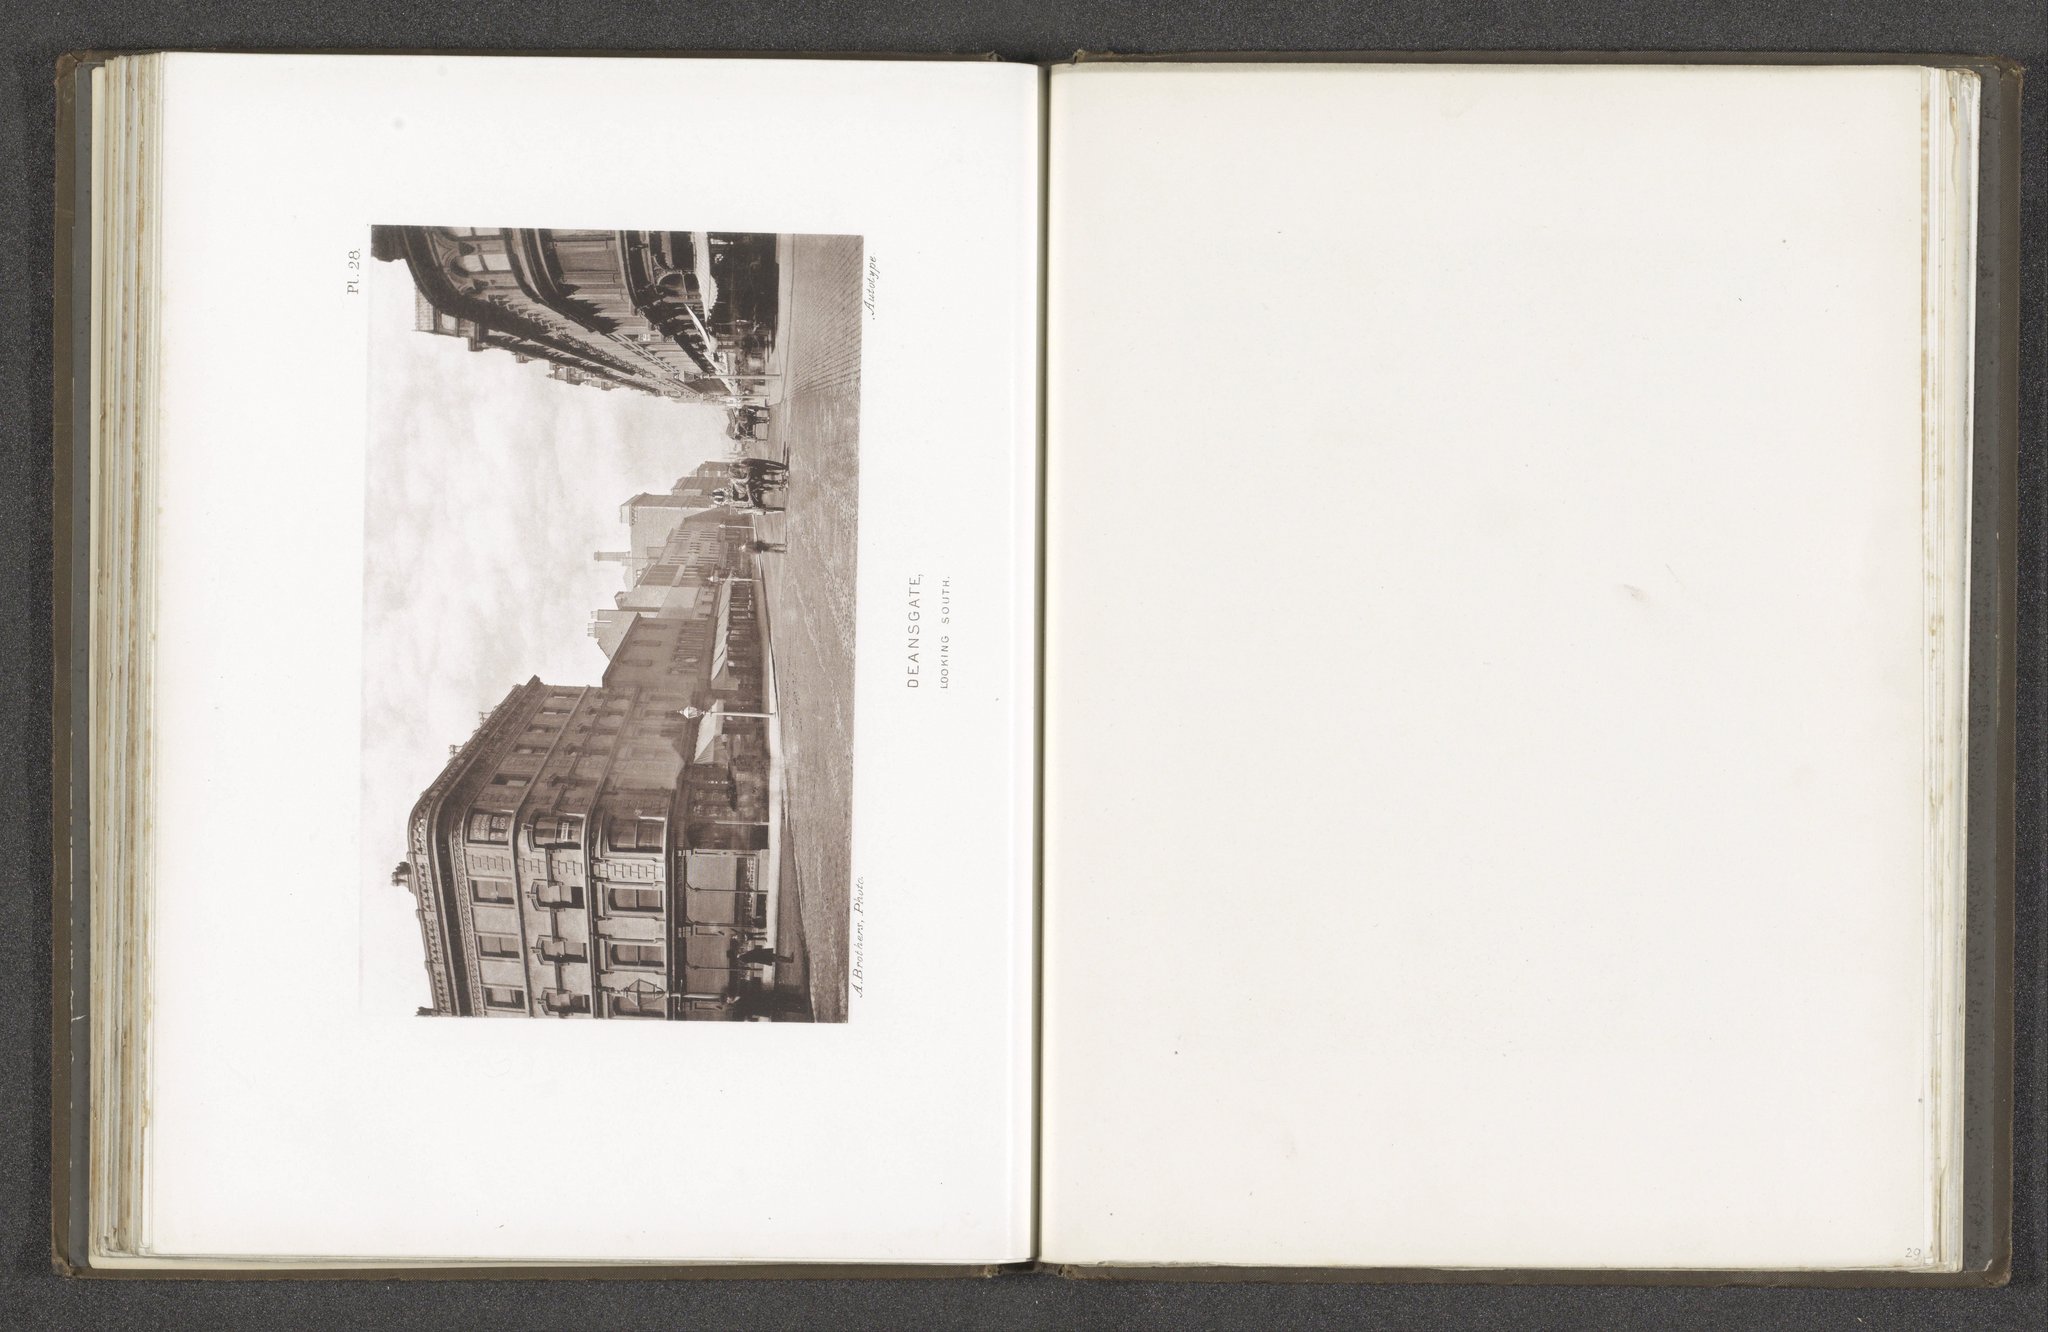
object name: page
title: Deansgate, looking south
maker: Anonymous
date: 1868-1878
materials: paper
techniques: photograph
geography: manchester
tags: shop, store, four-wheeled, animal-drawn vehicle, e.g.: cab, carriage, coach, street, manchester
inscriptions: number: ‘Pl. 28.’